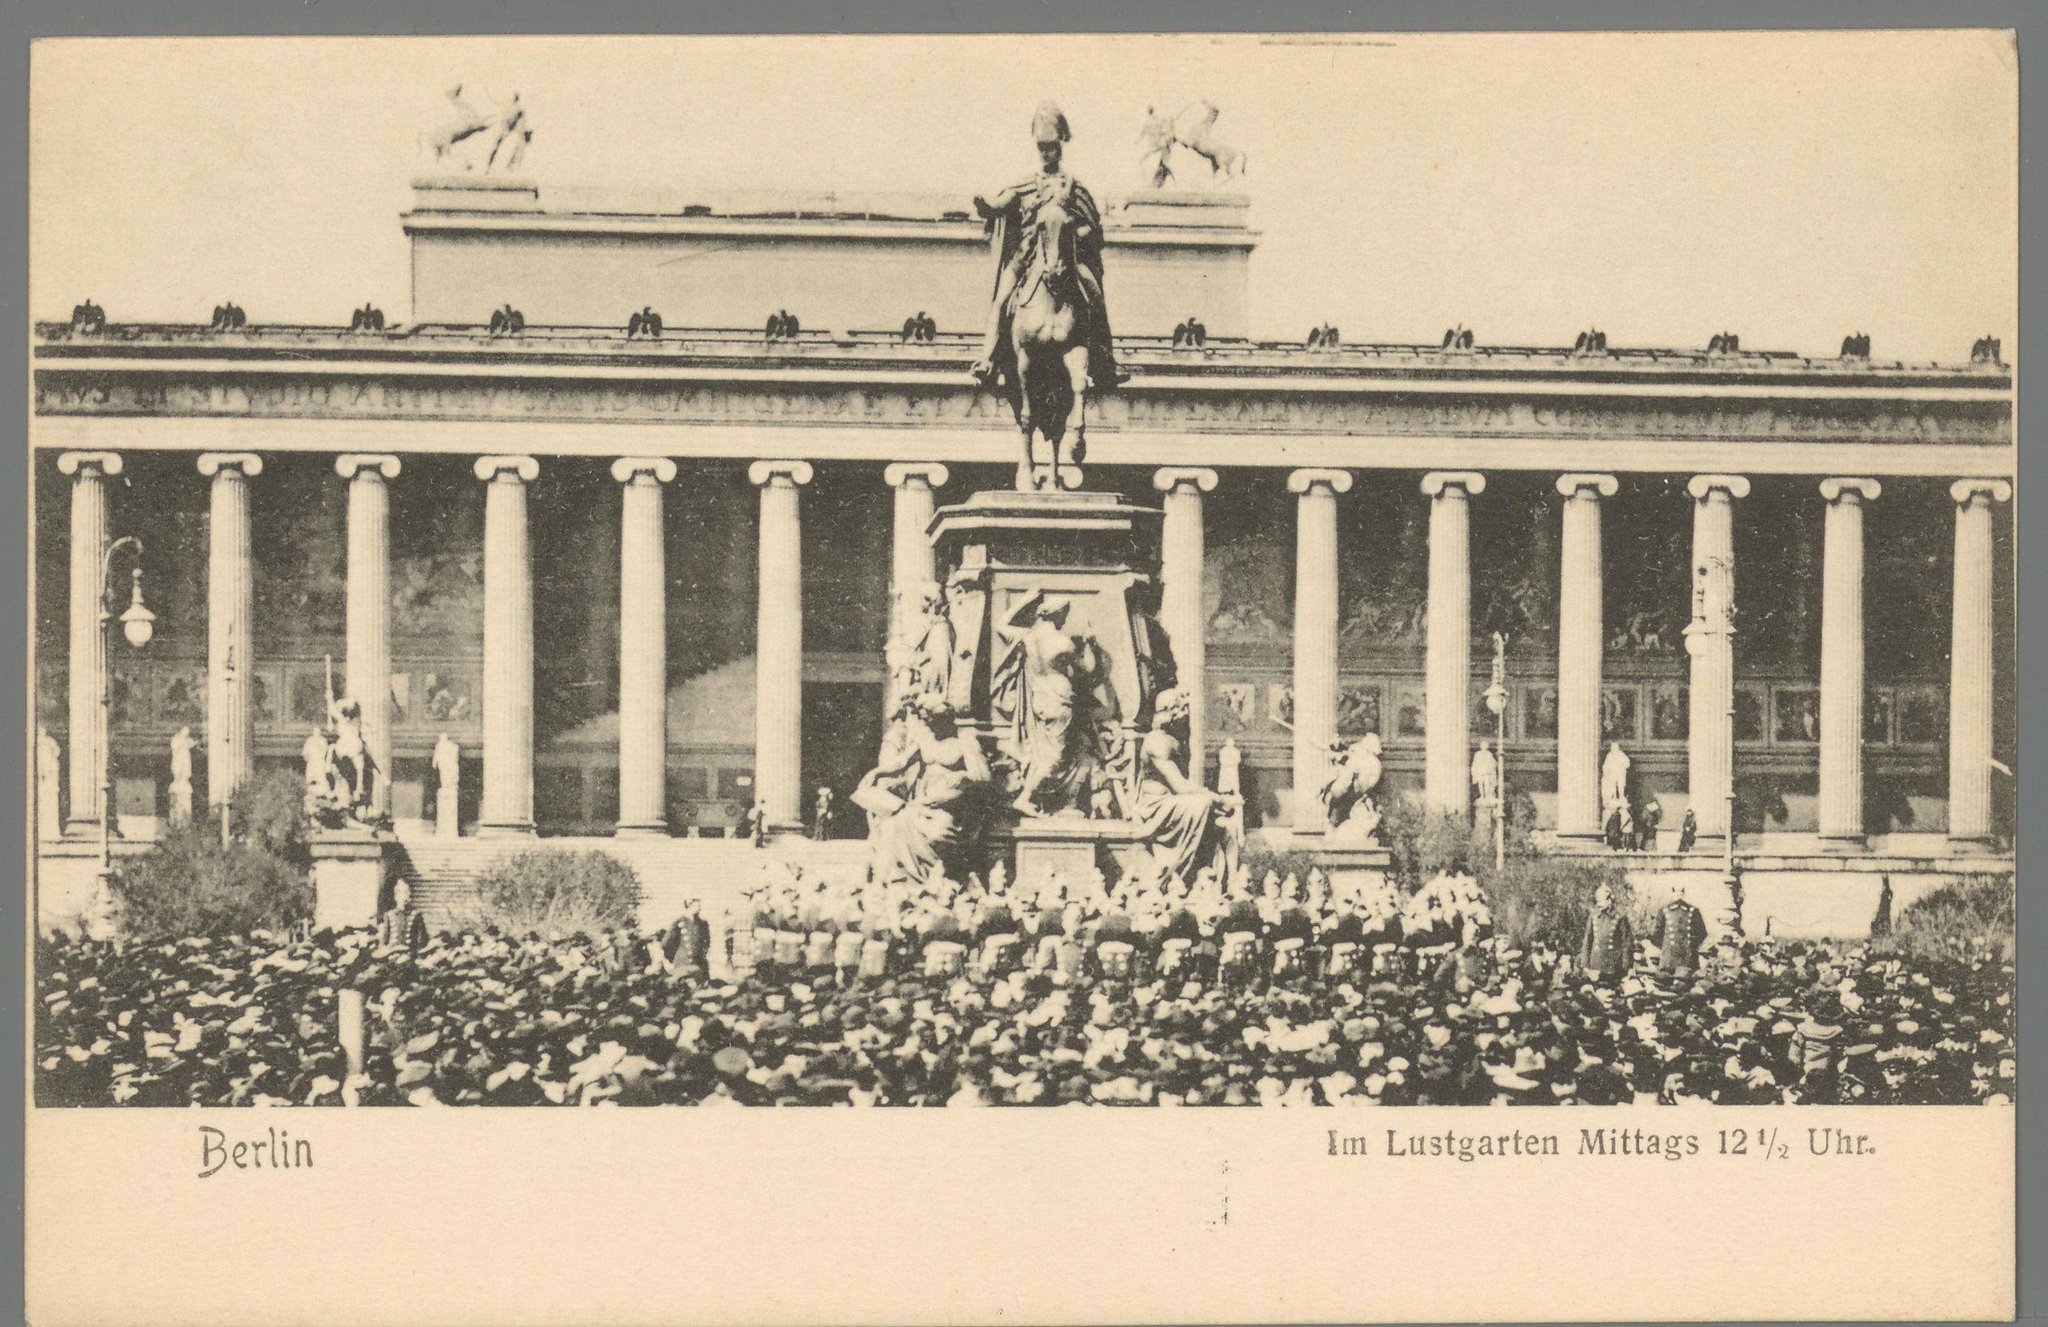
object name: ansichtkaart, prentbriefkaart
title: Berlin. Im Lustgarten Mittags 12½ Uhr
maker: Anonymous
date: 1885-1905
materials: cardboard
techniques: photograph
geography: berlin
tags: berlin, frederik willem iv (koning van pruisen), monument, statue, permanent exhibition, museum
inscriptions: stamp: ‘5’